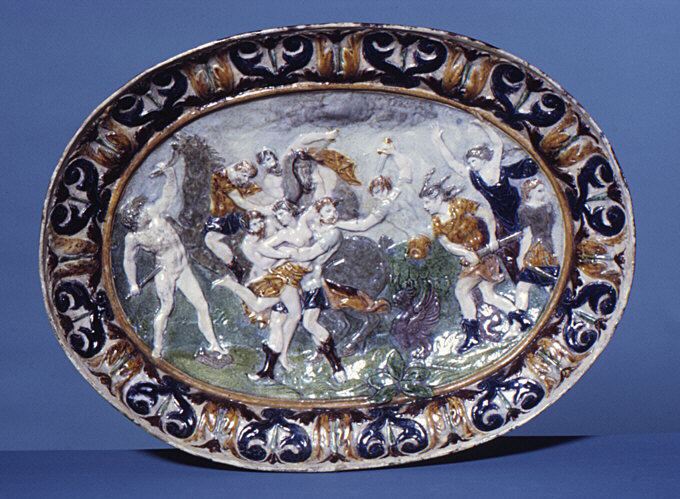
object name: dish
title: The Abduction of Hippodamia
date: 1567-1600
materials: earthenware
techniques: glazing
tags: swords,men,women